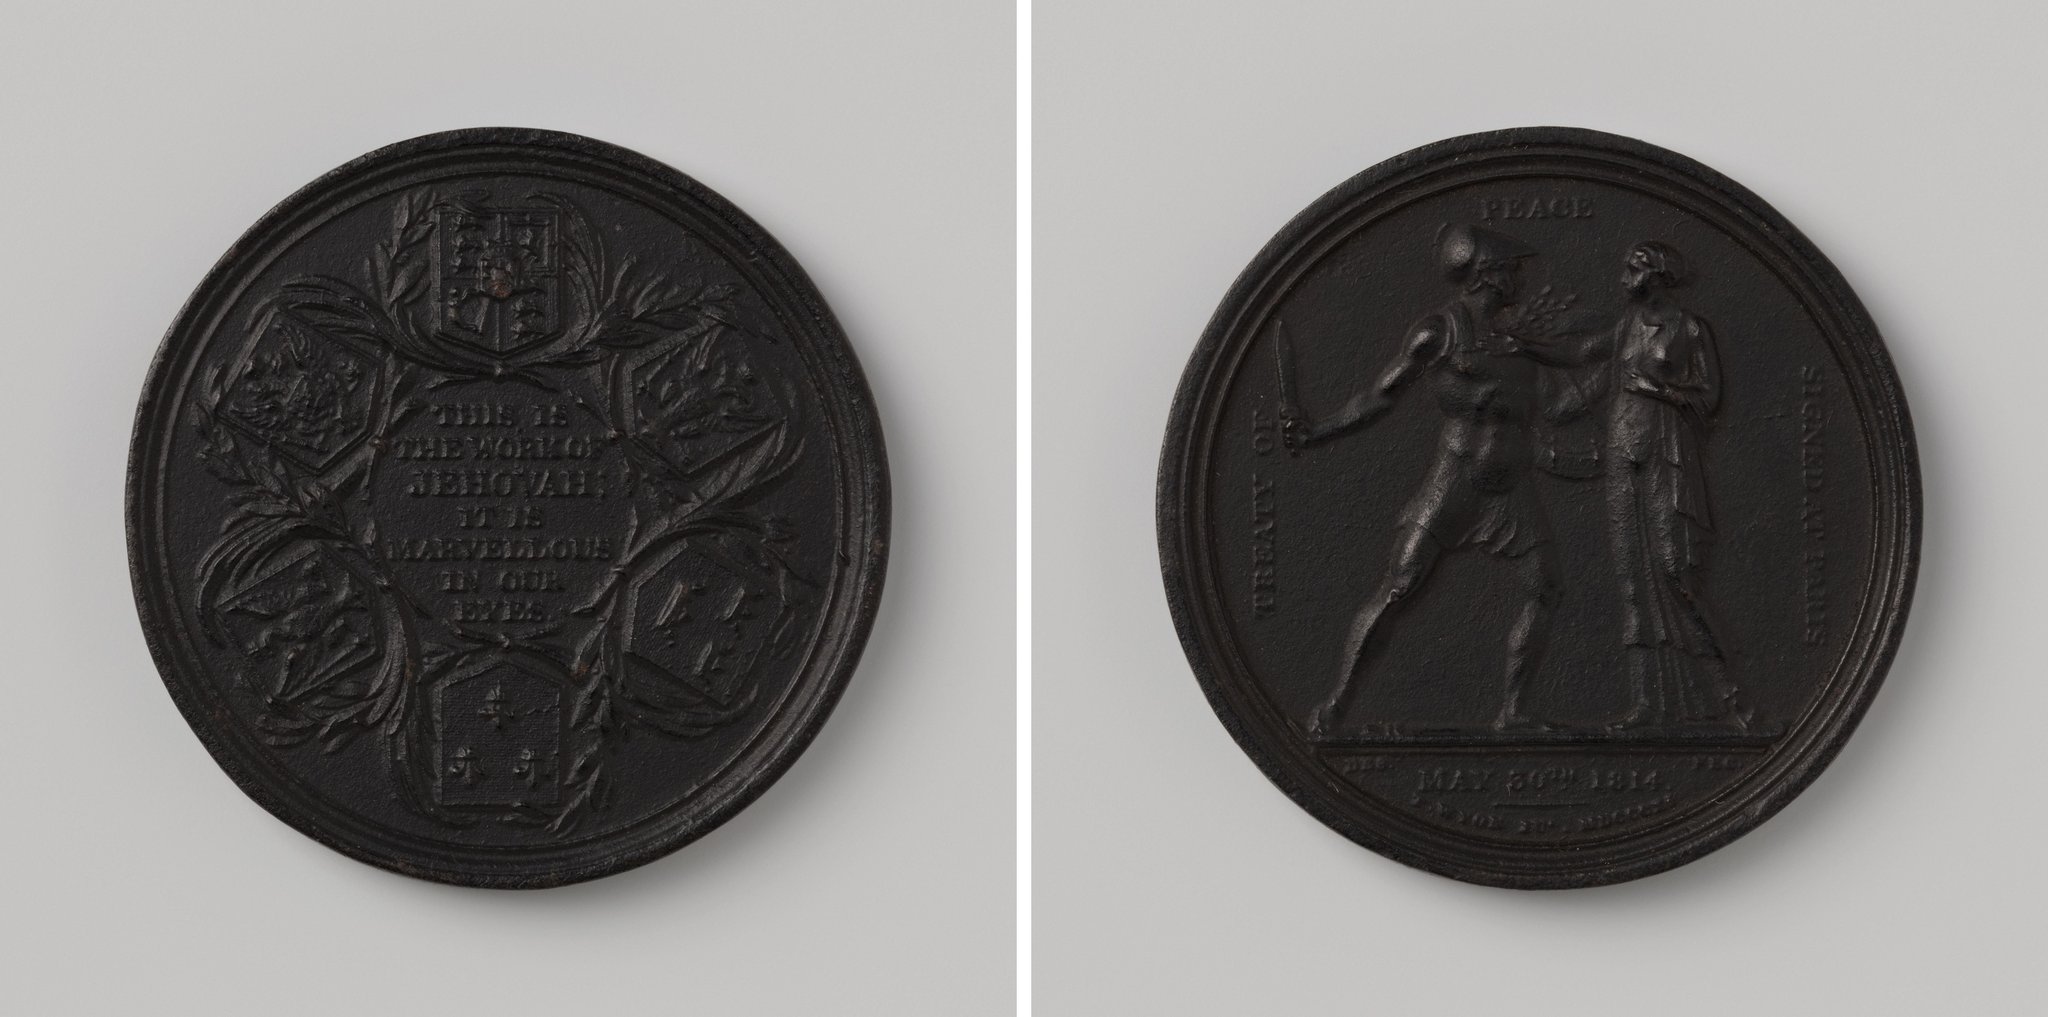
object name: medal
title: Eerste vrede van Parijs tussen Frankrijk en de geallieerden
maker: thomas wyon (ii)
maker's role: medailleur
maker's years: 1792-1817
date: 1815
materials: tin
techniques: striking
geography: london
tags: paris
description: Tinnen penning. Voorzijde: opschrift binnen rand van zes met palm- en olijftak omgeven wapenschilden. Keerzijde: Vrede houdt olijftak voor aan Mars met schild en getrokken zwaard in handen binnen omschrift; afsnede: opschrift